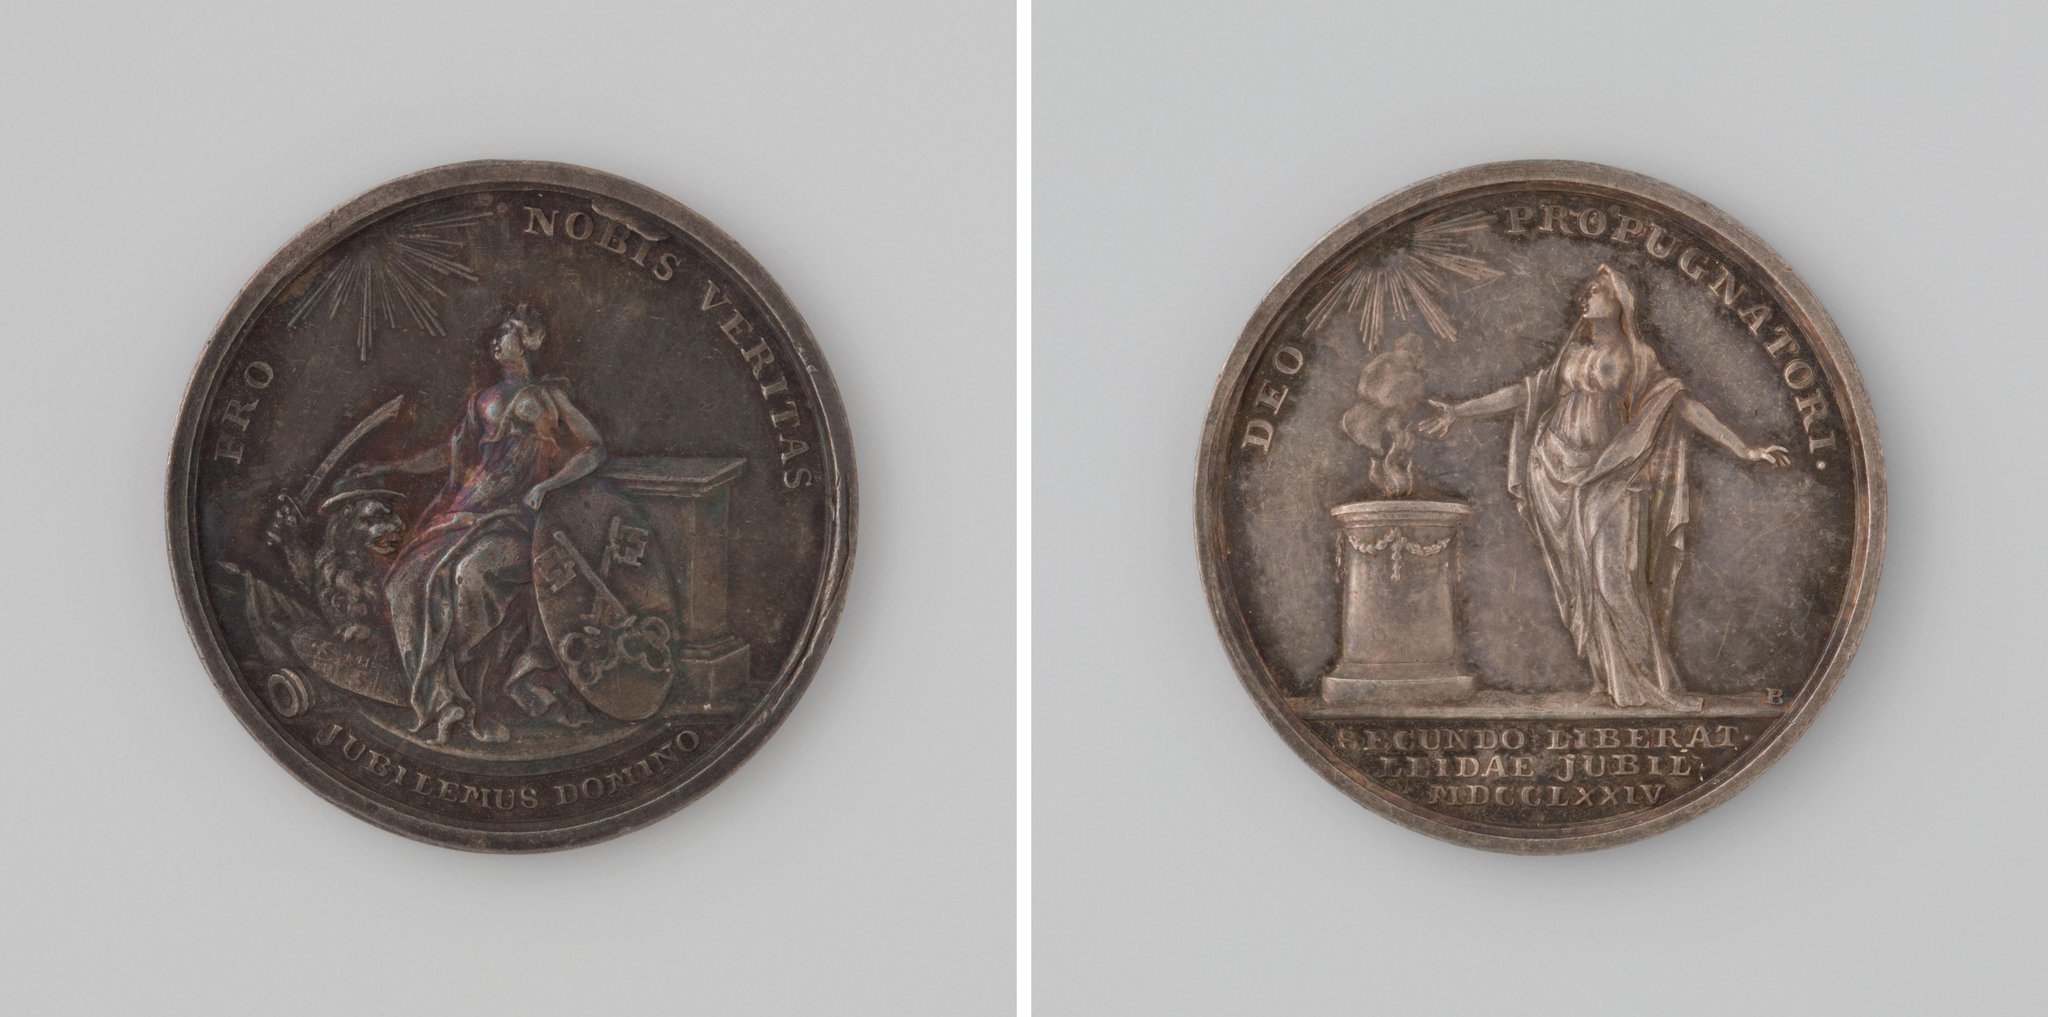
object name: history medal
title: Tweehonderdste verjaardag van het ontzet van Leiden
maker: theodorus victor van berckel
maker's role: mintmaster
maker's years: 1739-1808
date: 1774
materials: silver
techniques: striking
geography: brussels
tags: leiden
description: Zilveren penning. Voorzijde: beschenen door hemellicht houdt stad Leiden, afgebeeld als gekroonde vrouw met wapenschild zittend tegen zuil, vrijheidshoed boven leeuw, die met zwaard in zijn klauw op stapel vaandels, wapenschild en wapentuig ligt binnen omschrift. Keerzijde: gesluierde vrouw, voorstellende Godsdienst, staat bij brandend altaar, beschenen door hemellicht binnen omschrift; afsnede: opschrift